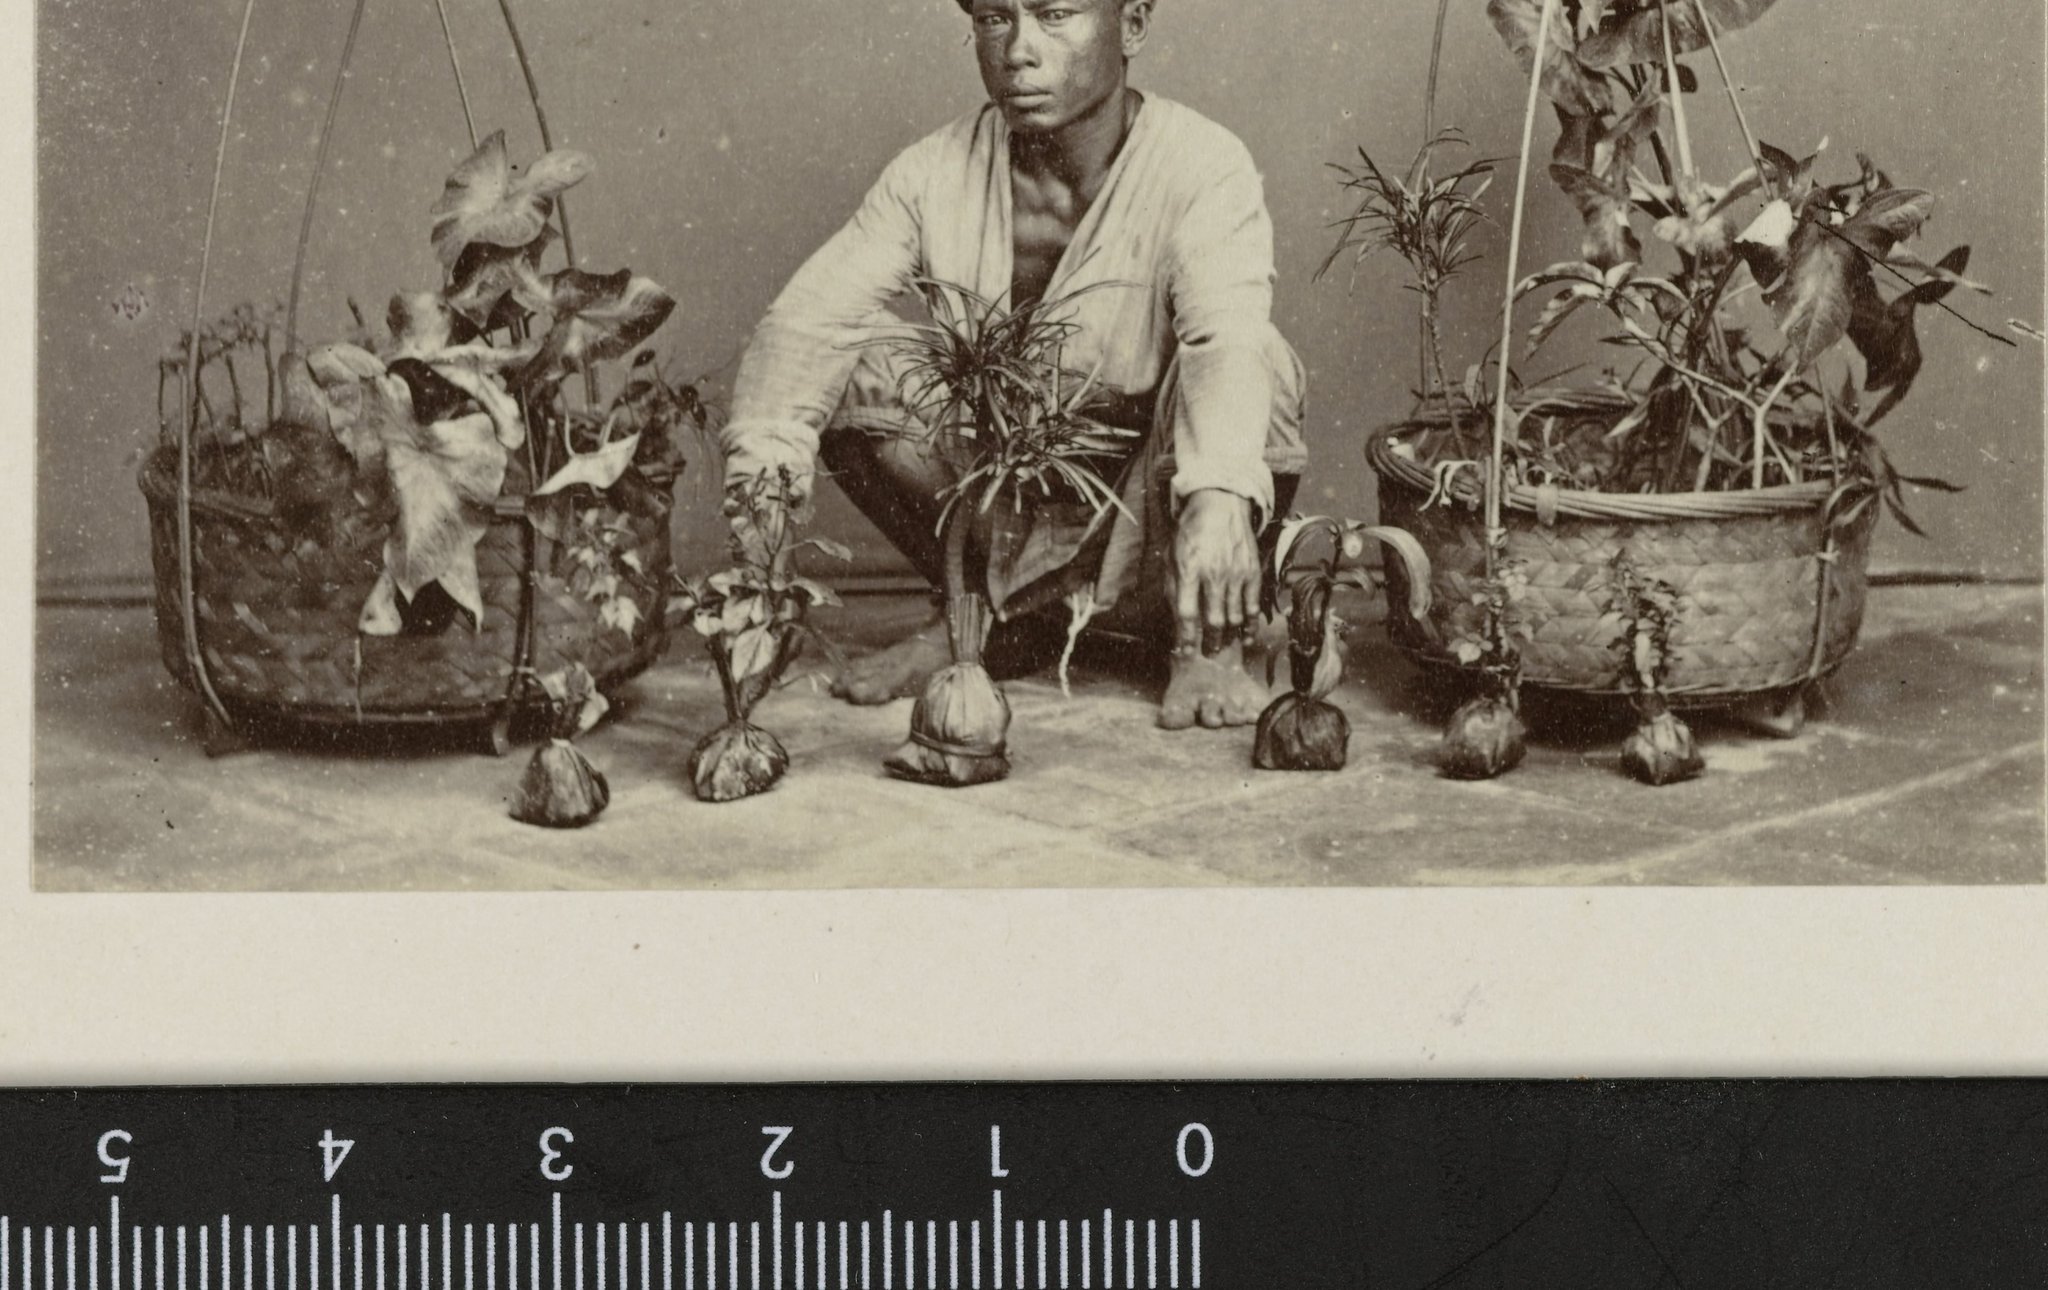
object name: photograph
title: Javaanse drager met planten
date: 1860-1880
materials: photographic support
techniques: albumen print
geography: batavia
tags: carrying something with carrying-pole, ornamental plants, java, batavia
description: Studioportret van een Javaanse drager met planten, een plantenverkoper. Ingeplakte foto in het fotoalbum getiteld: Gezichten van Java.